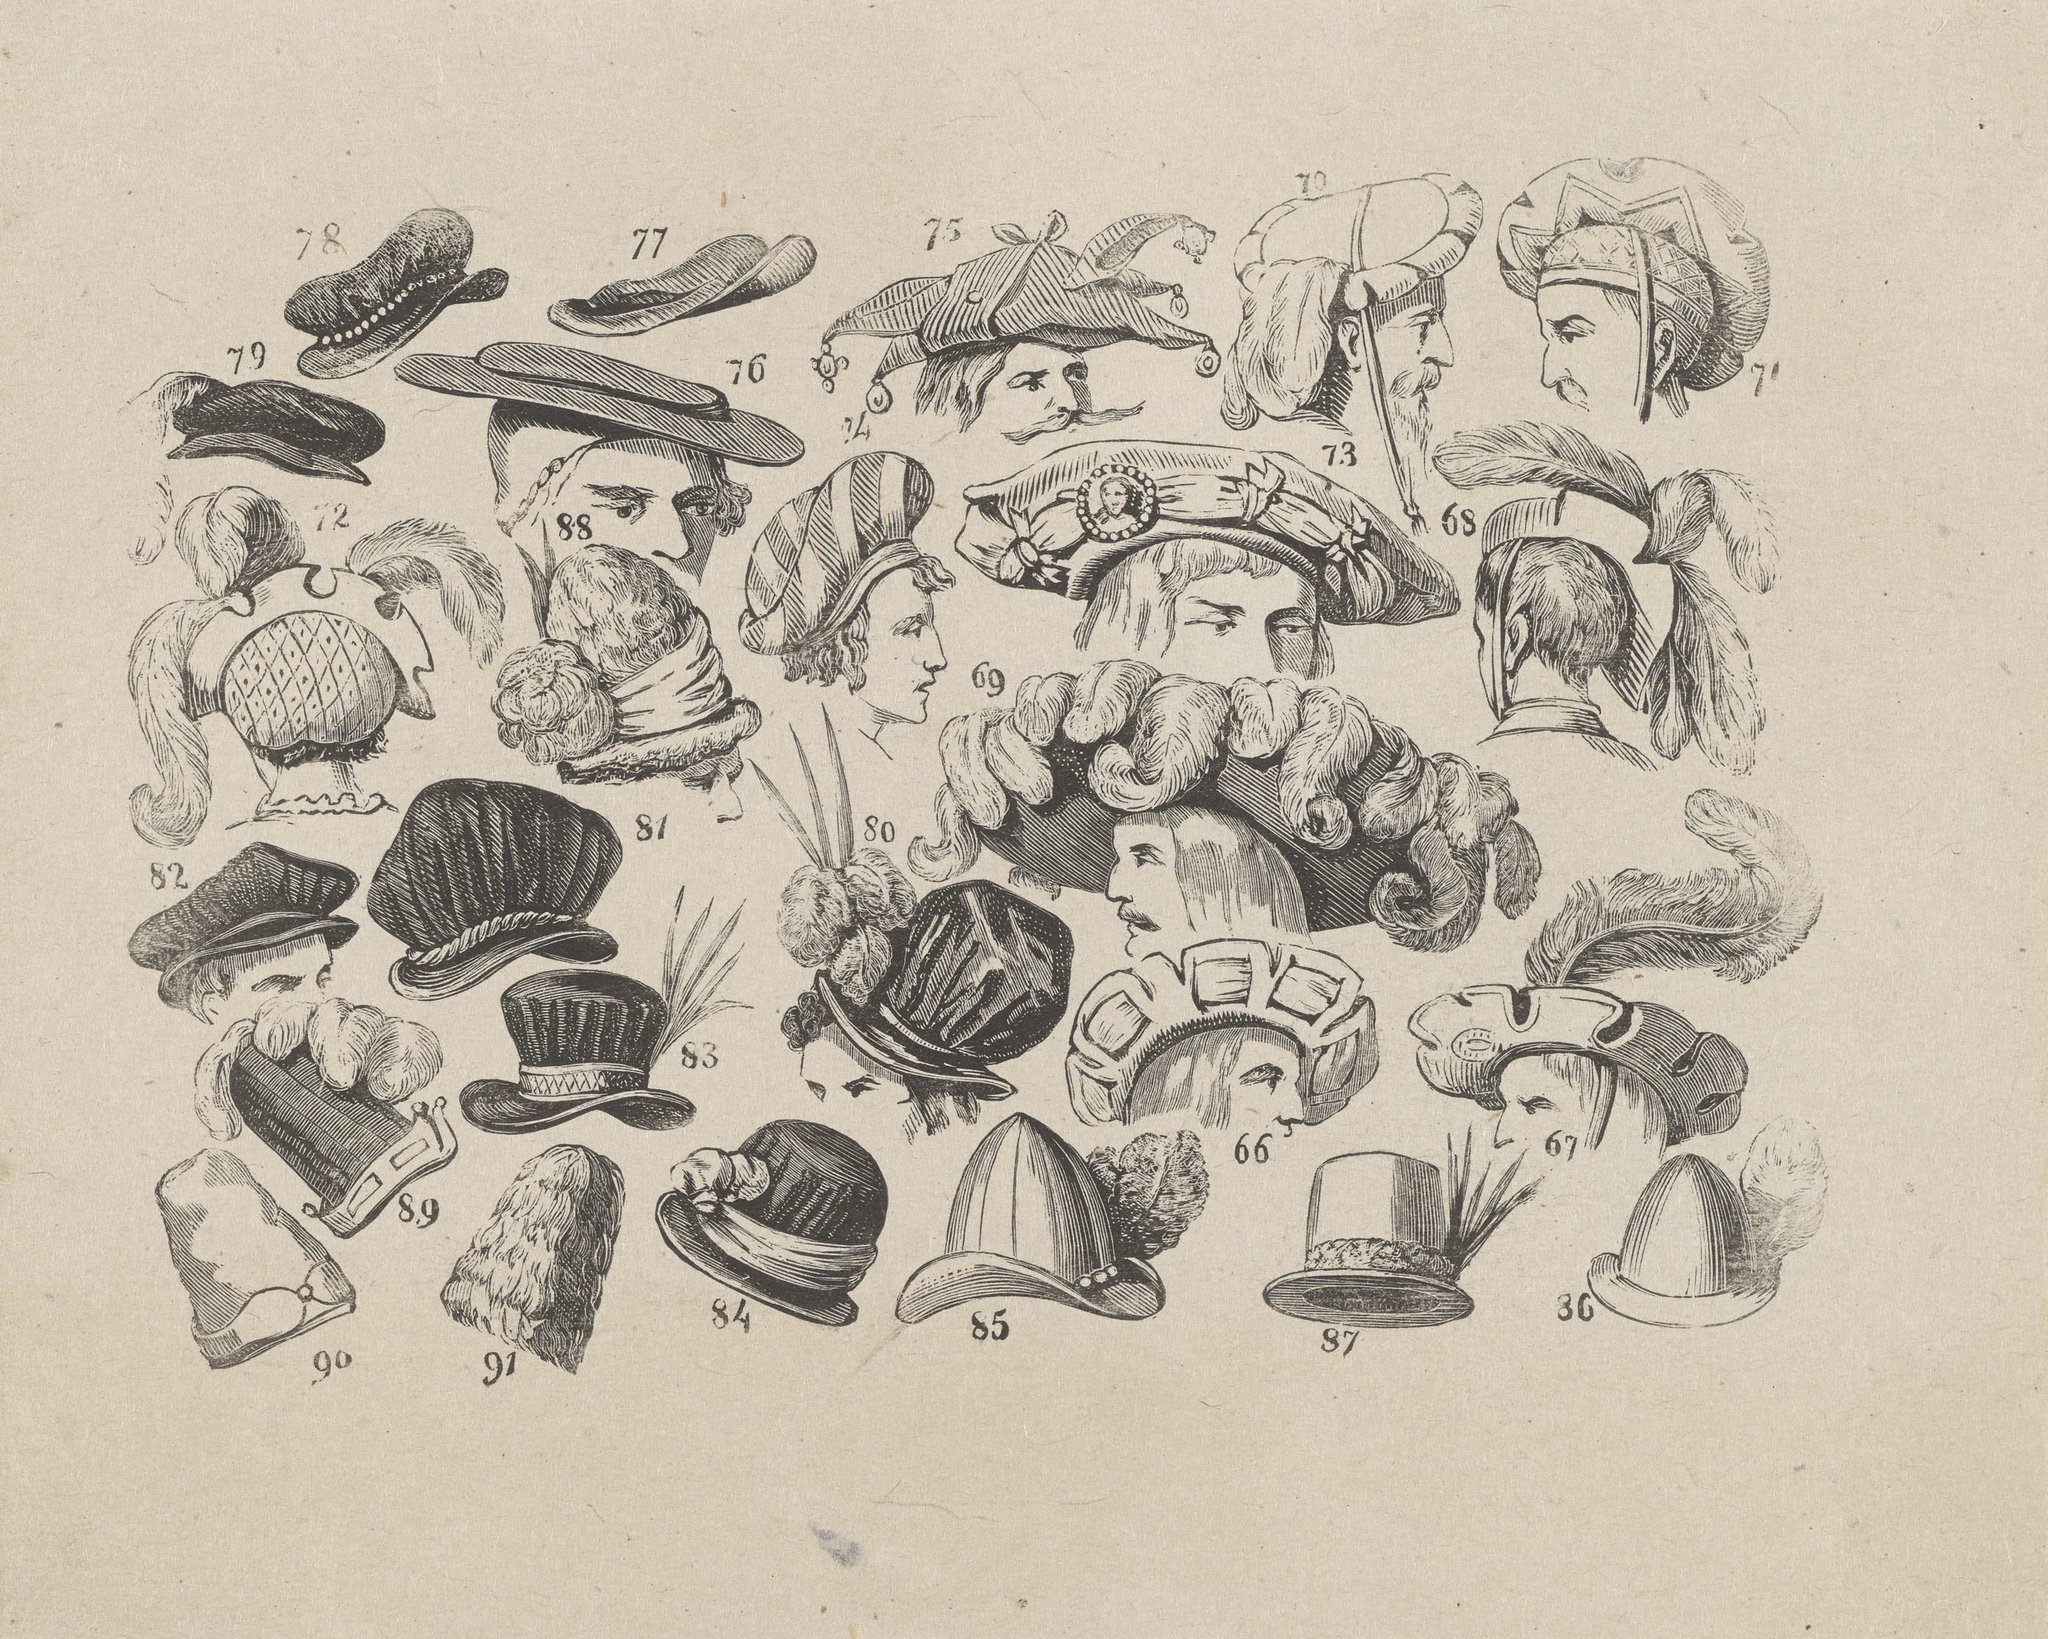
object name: print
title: Verschillende soorten hoeden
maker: isaac weissenbruch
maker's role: print maker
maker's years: 1826-1912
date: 1836-1912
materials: paper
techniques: engraving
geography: netherlands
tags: head-gear